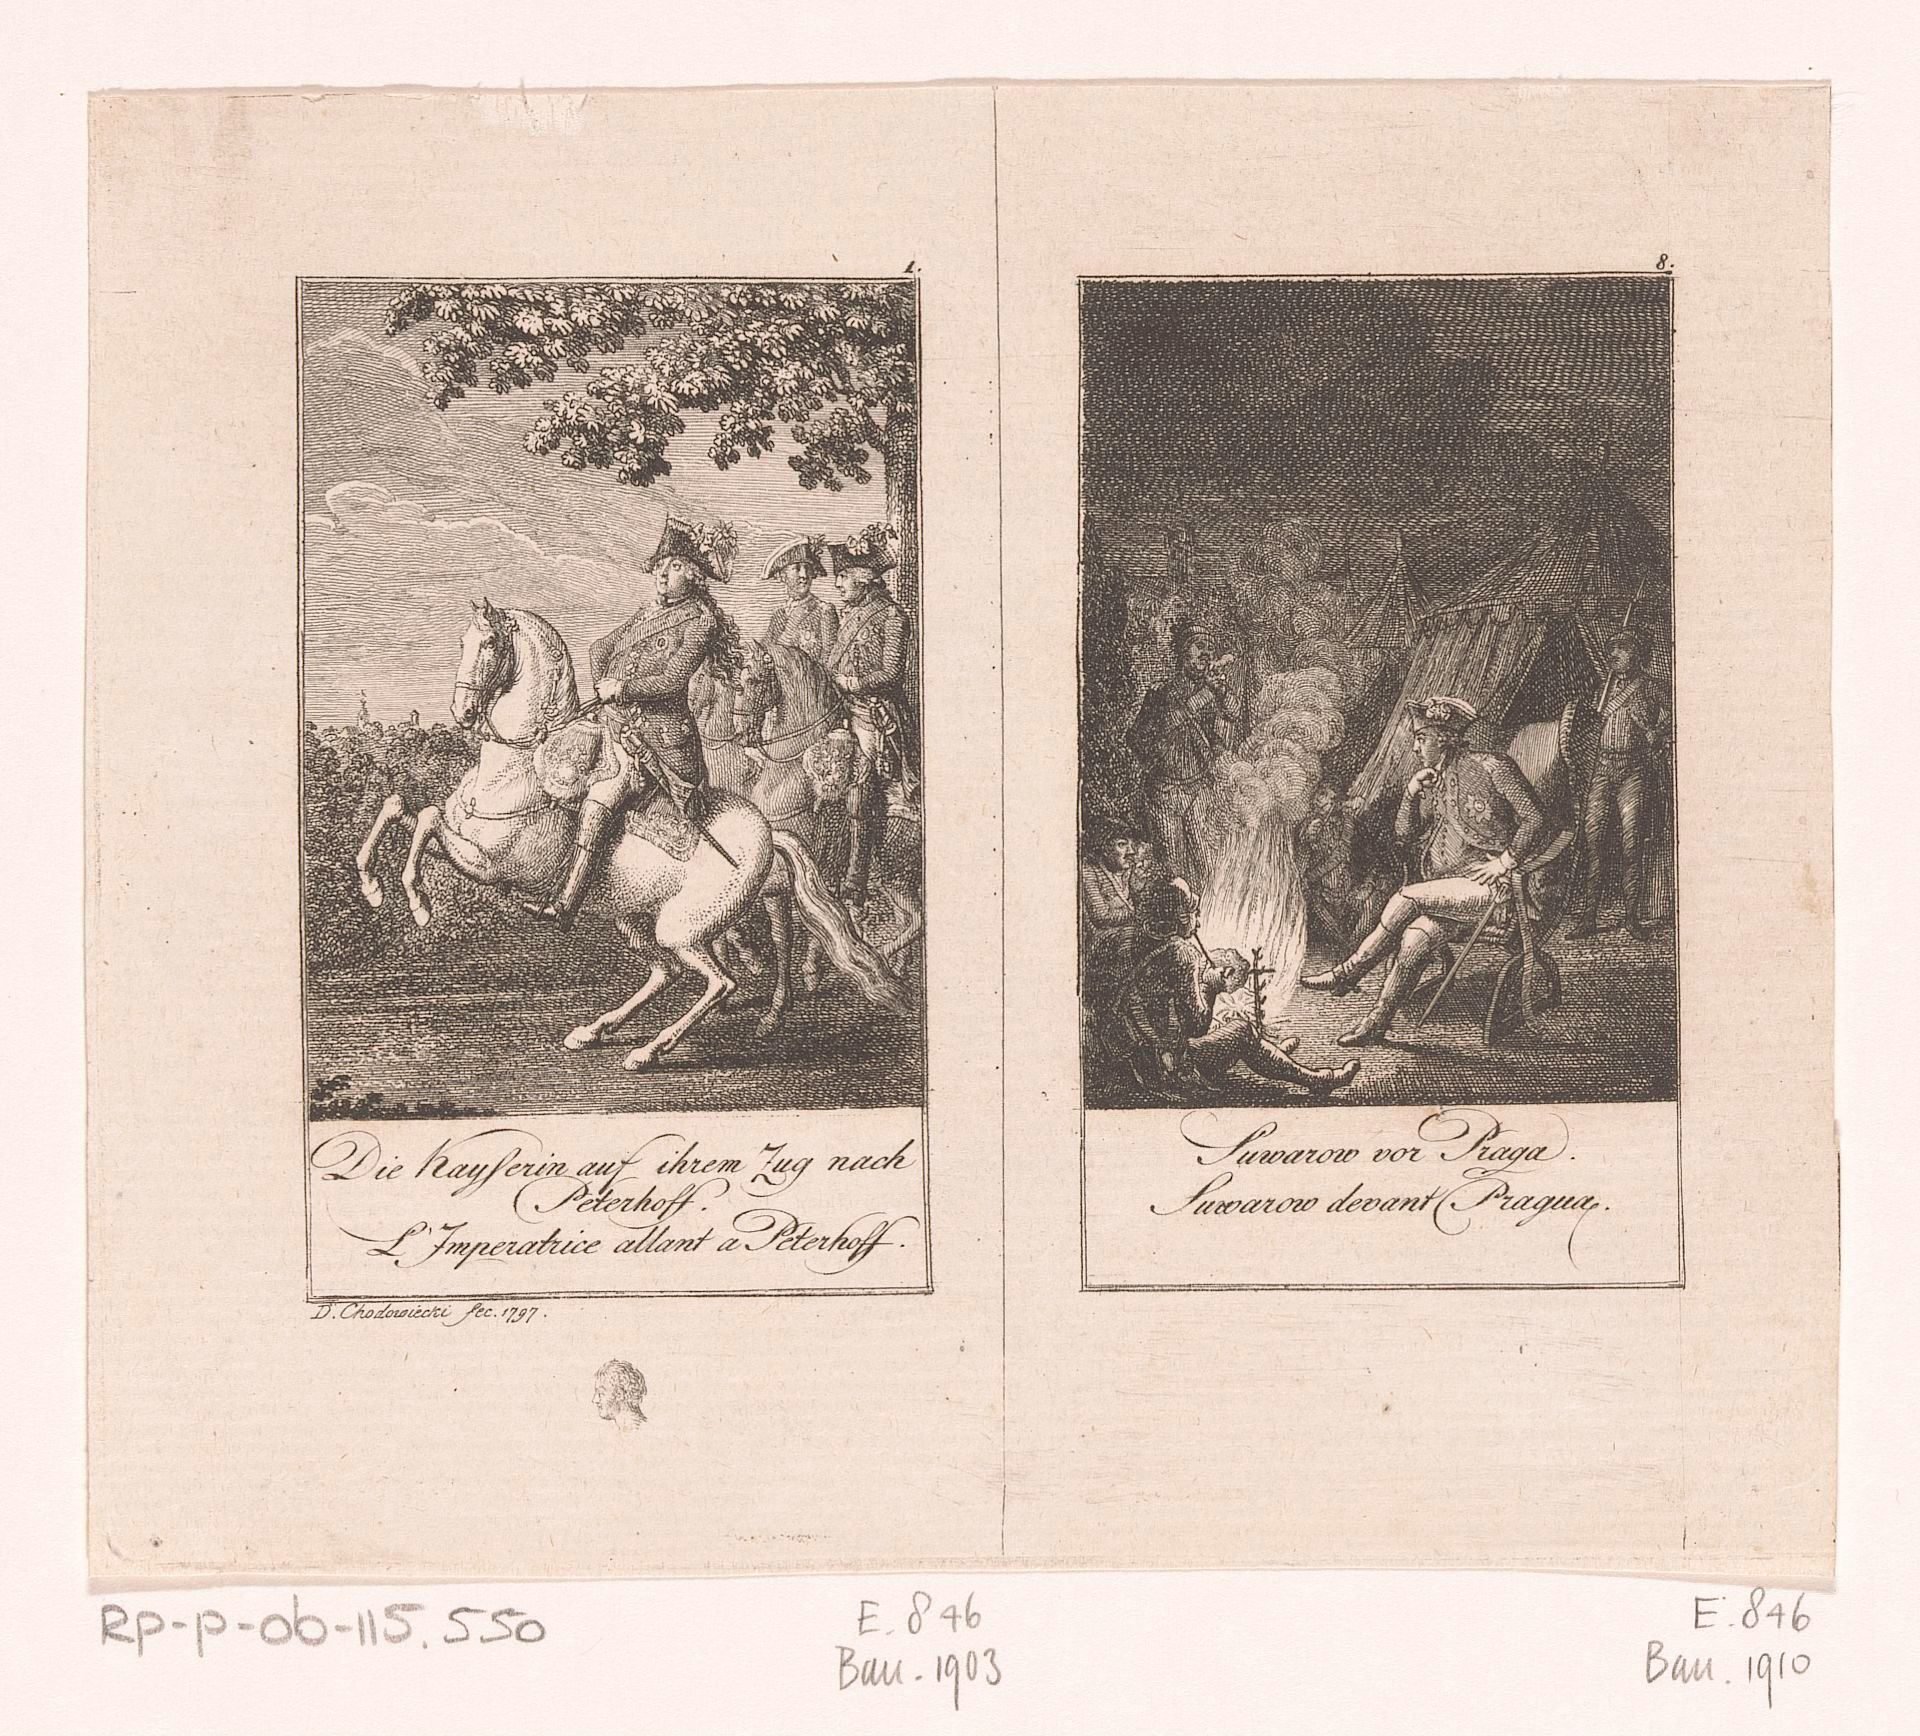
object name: print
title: Twee voorstellingen uit de geschiedenis van Catharina de Grote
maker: daniel nikolaus chodowiecki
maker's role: draughtsman, print maker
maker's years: 1726-1801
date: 1797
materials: paper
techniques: etching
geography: berlin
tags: catharina de grote, riding a horse, ass, or mule; rider, horseman, (military) camp with tents, history, camp-fire; watch-fire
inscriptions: collector's mark: Lugt 2228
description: Latere staat gebruikt voor: Historisch-genealogischer Kalender auf das Gemeinjahr 1798. Katharina II. Ein historischer Versuch (...). Berlijn: Johann Friedrich Unger, [1797].